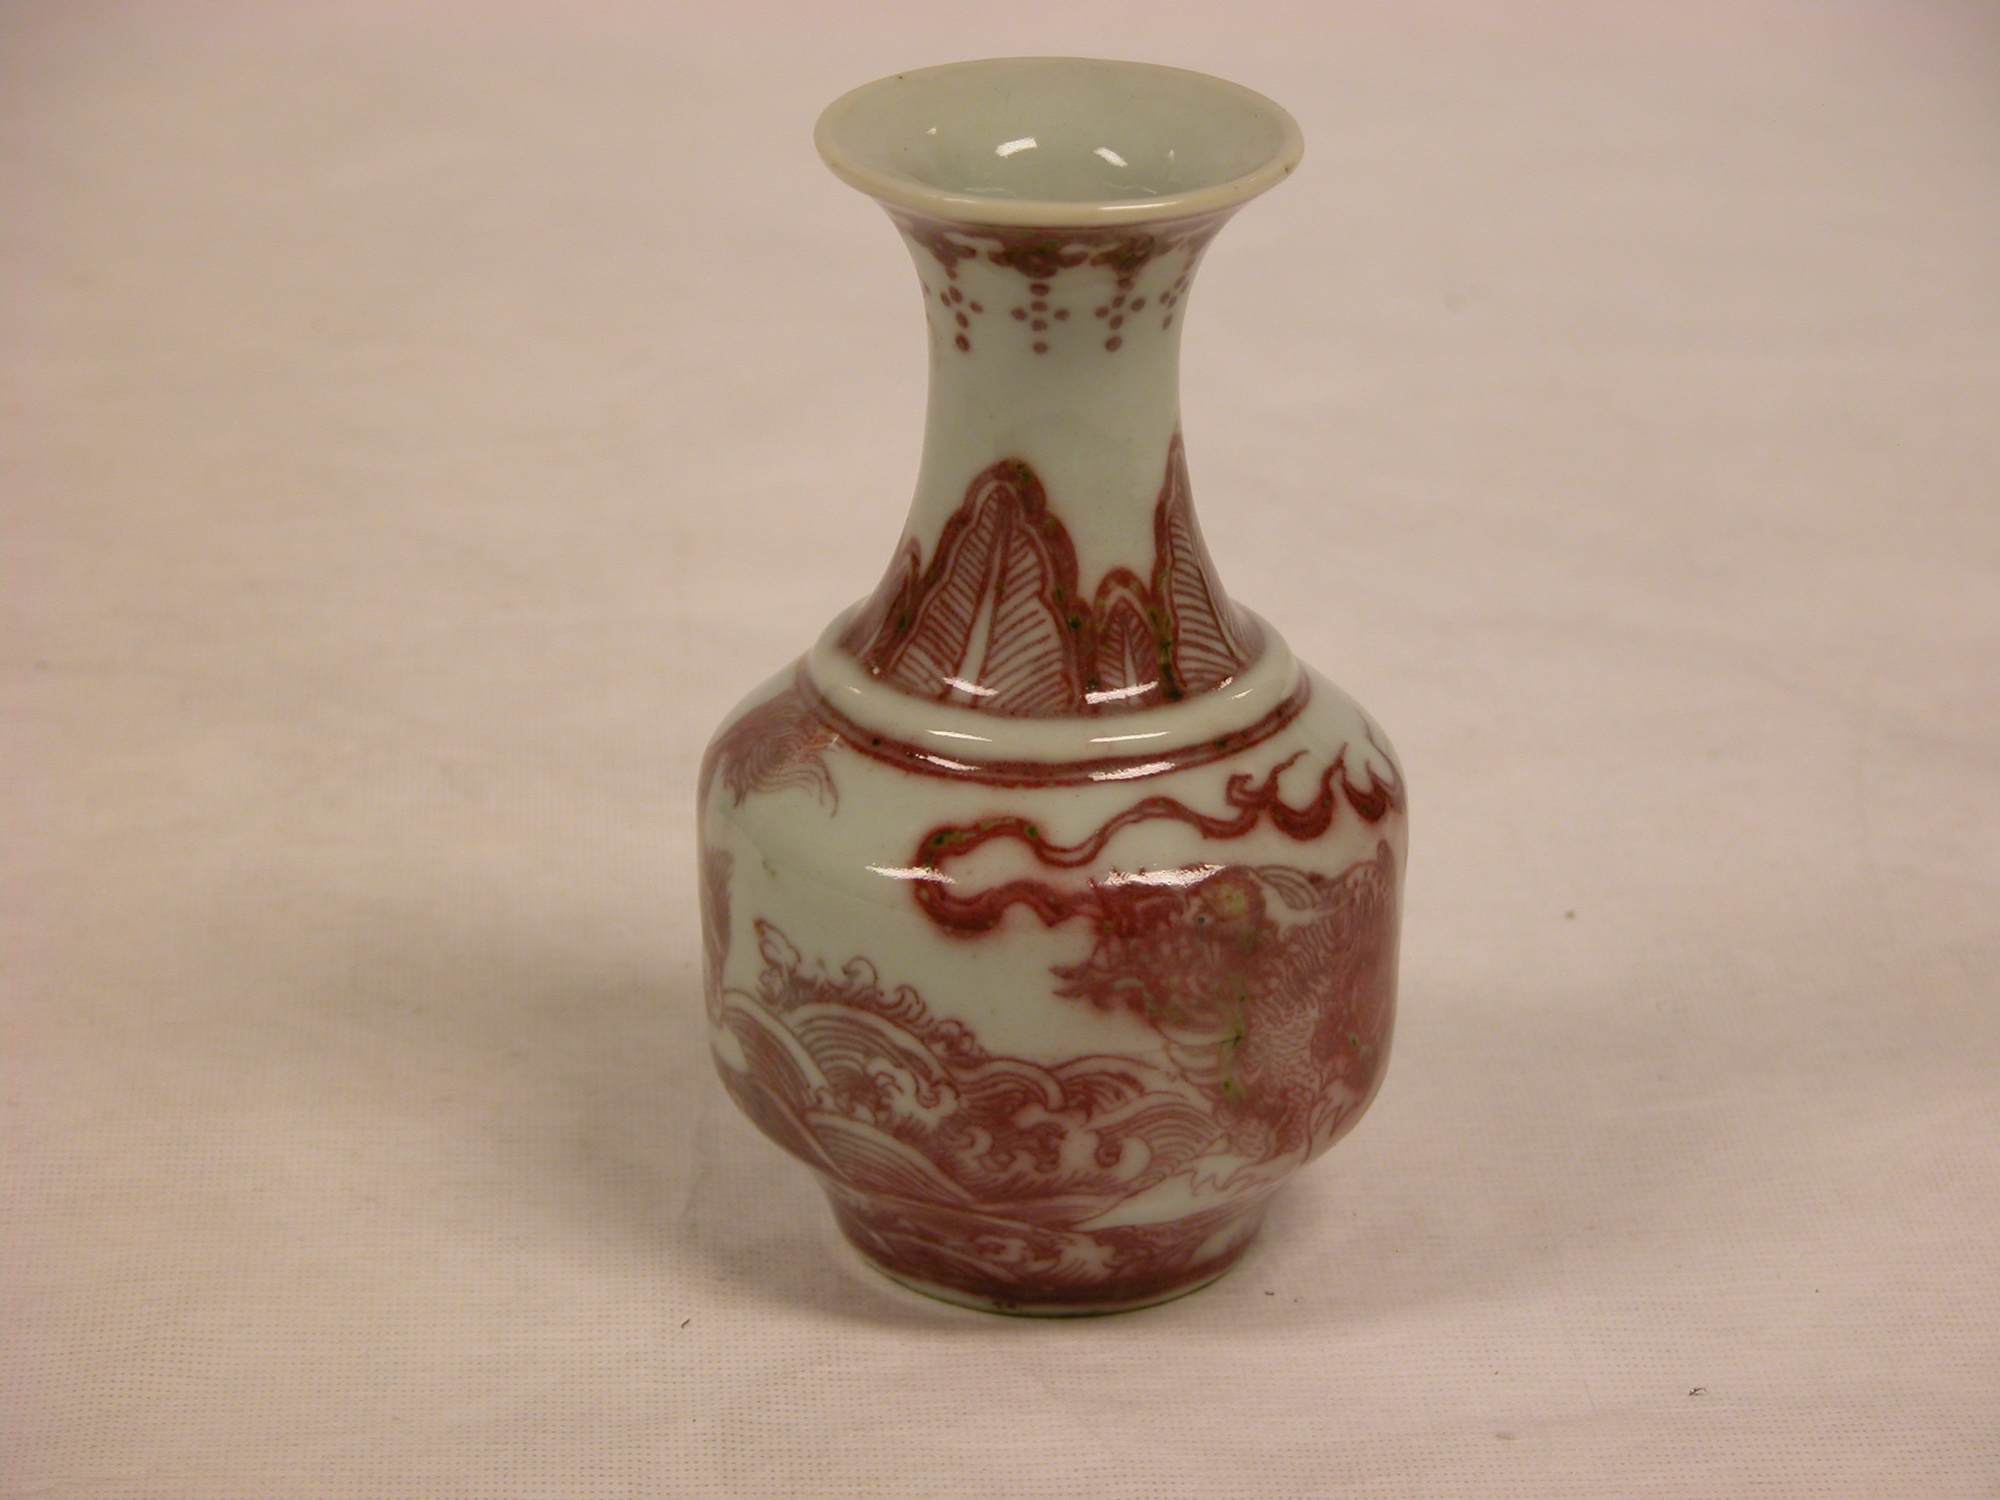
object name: vase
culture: chinese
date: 1426-1435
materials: porcelain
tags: mythical creatures,waves